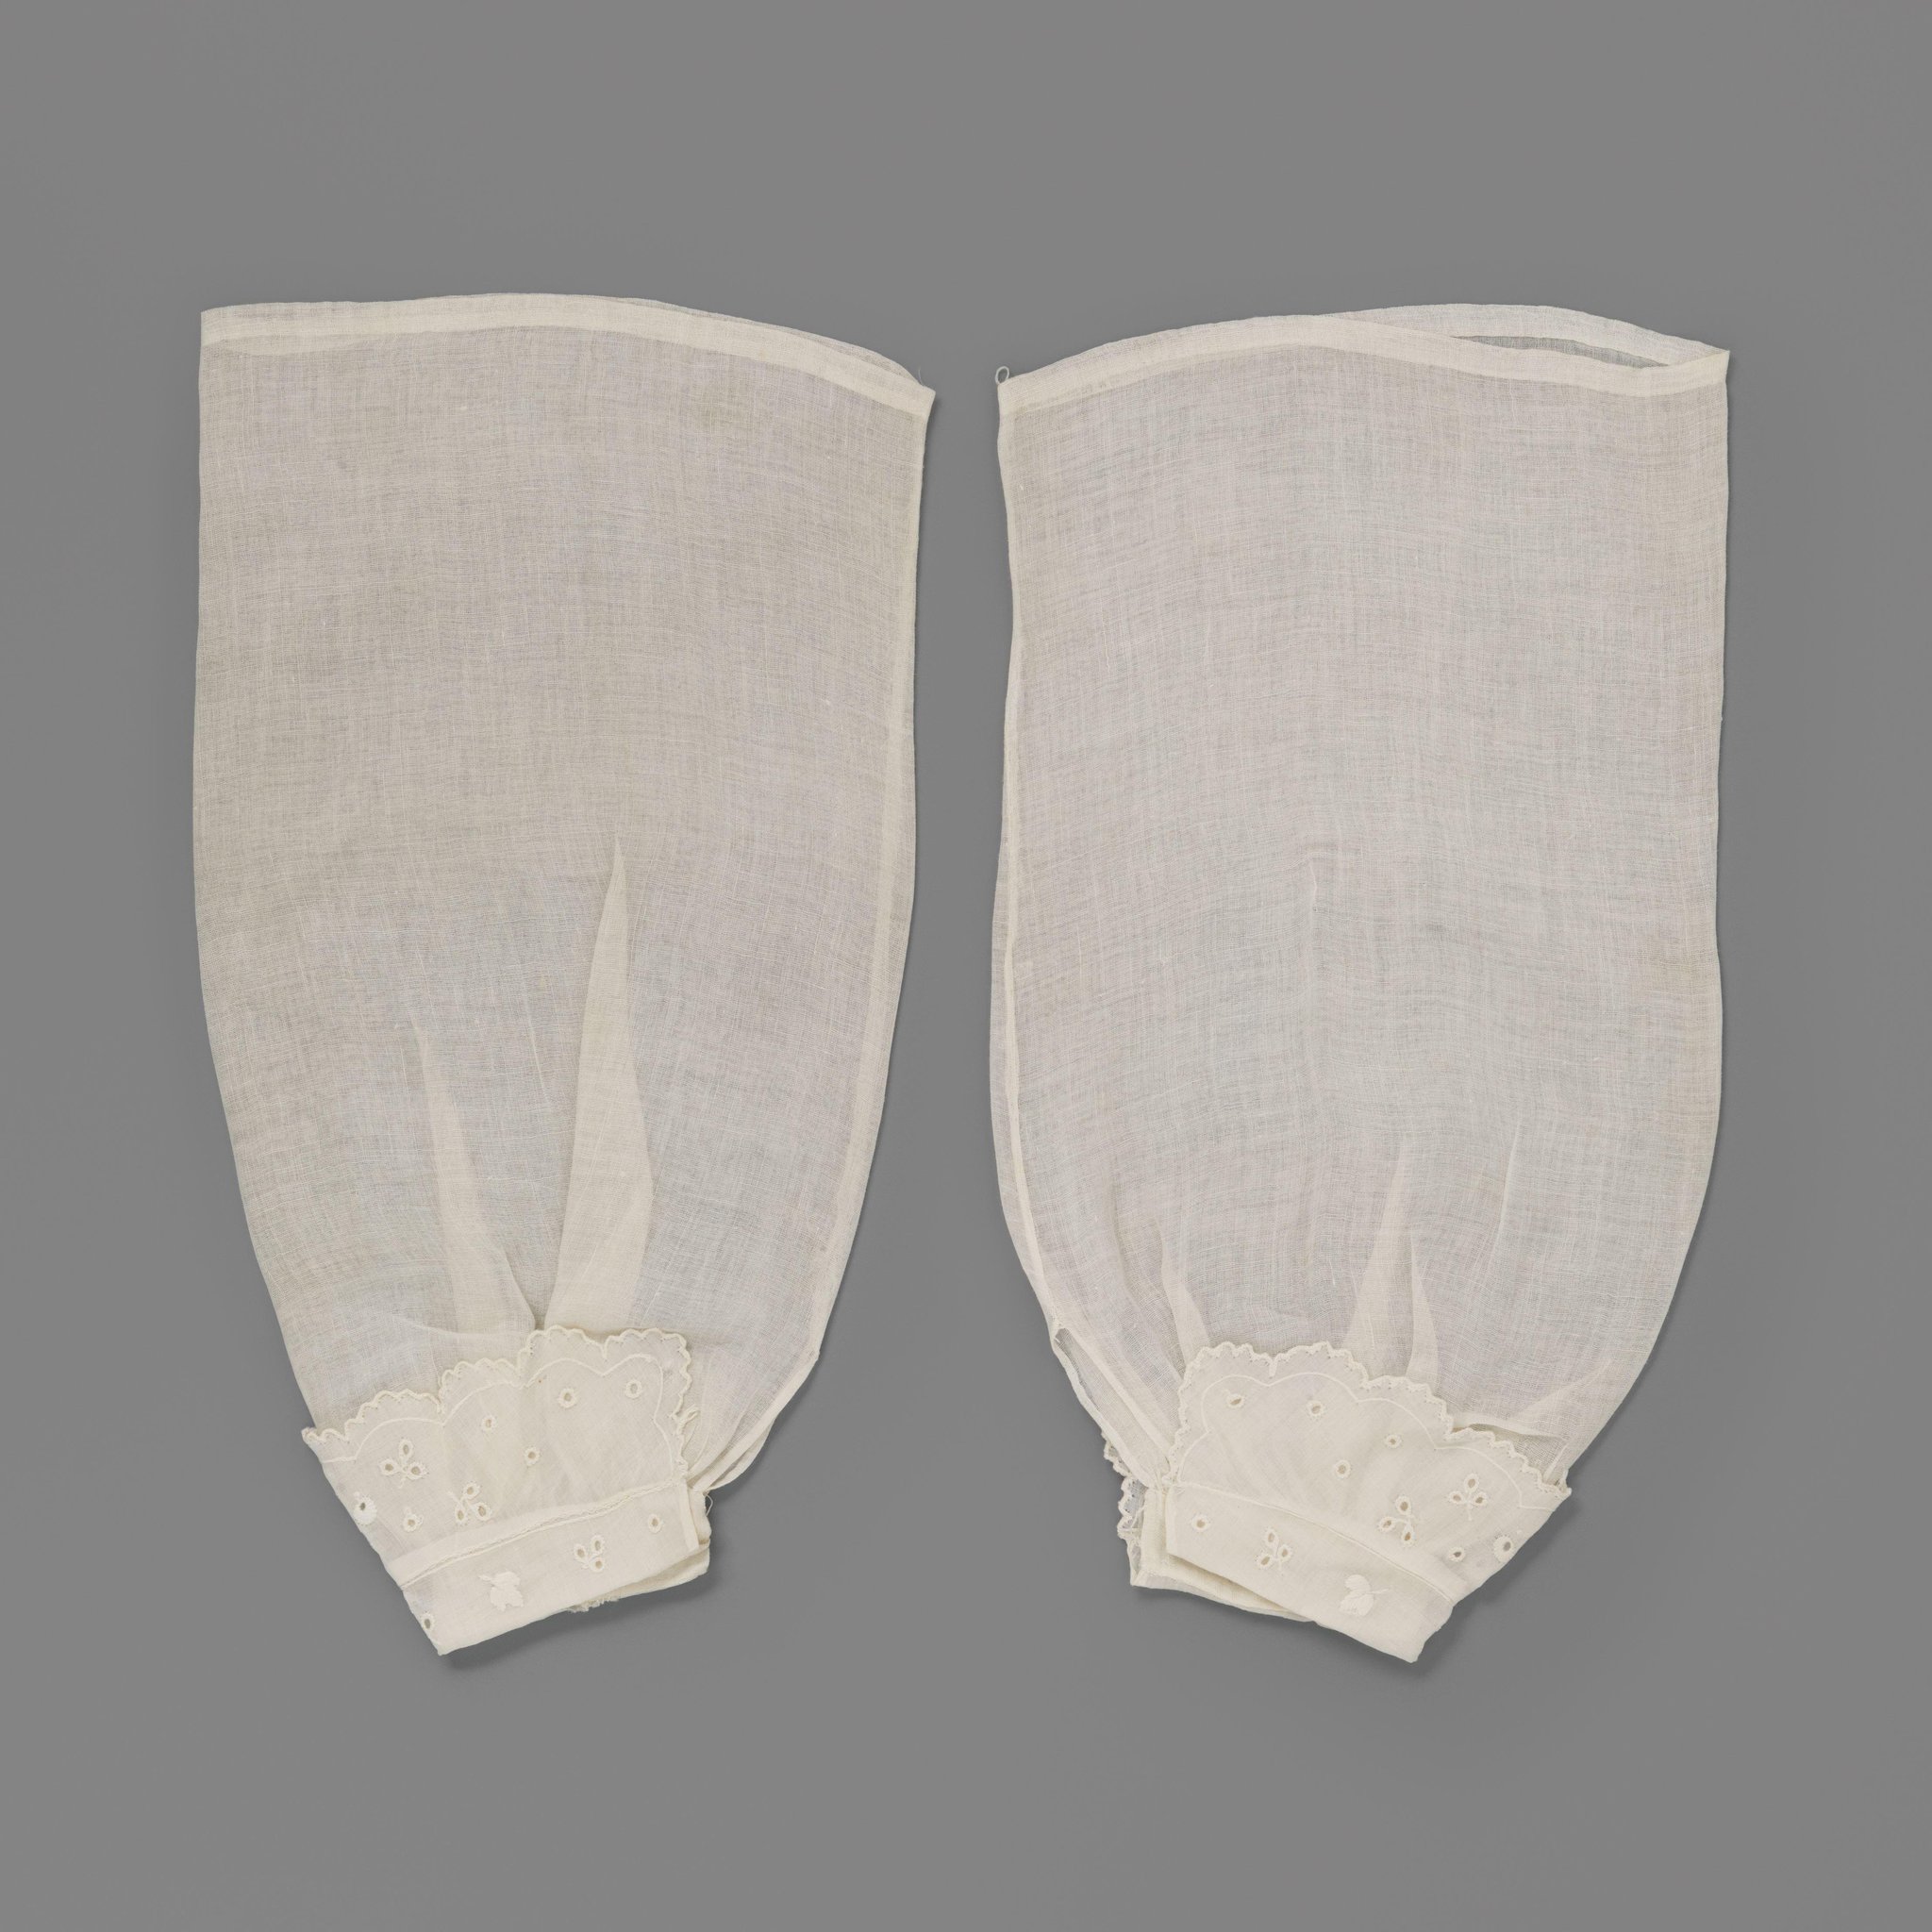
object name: womenswear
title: Ondermouw van katoenbatist met Engels borduurwerk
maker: Anonymous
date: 1850-1900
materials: textile, cotton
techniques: embroidered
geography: western europe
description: Ondermouw van katoenbatist met Engels borduurwerk. De mouw heeft een omgeslagen manchet van schuin op de draad geknipte batist, versierd met wit borduurwerk voorzien van een geschulpte rand.